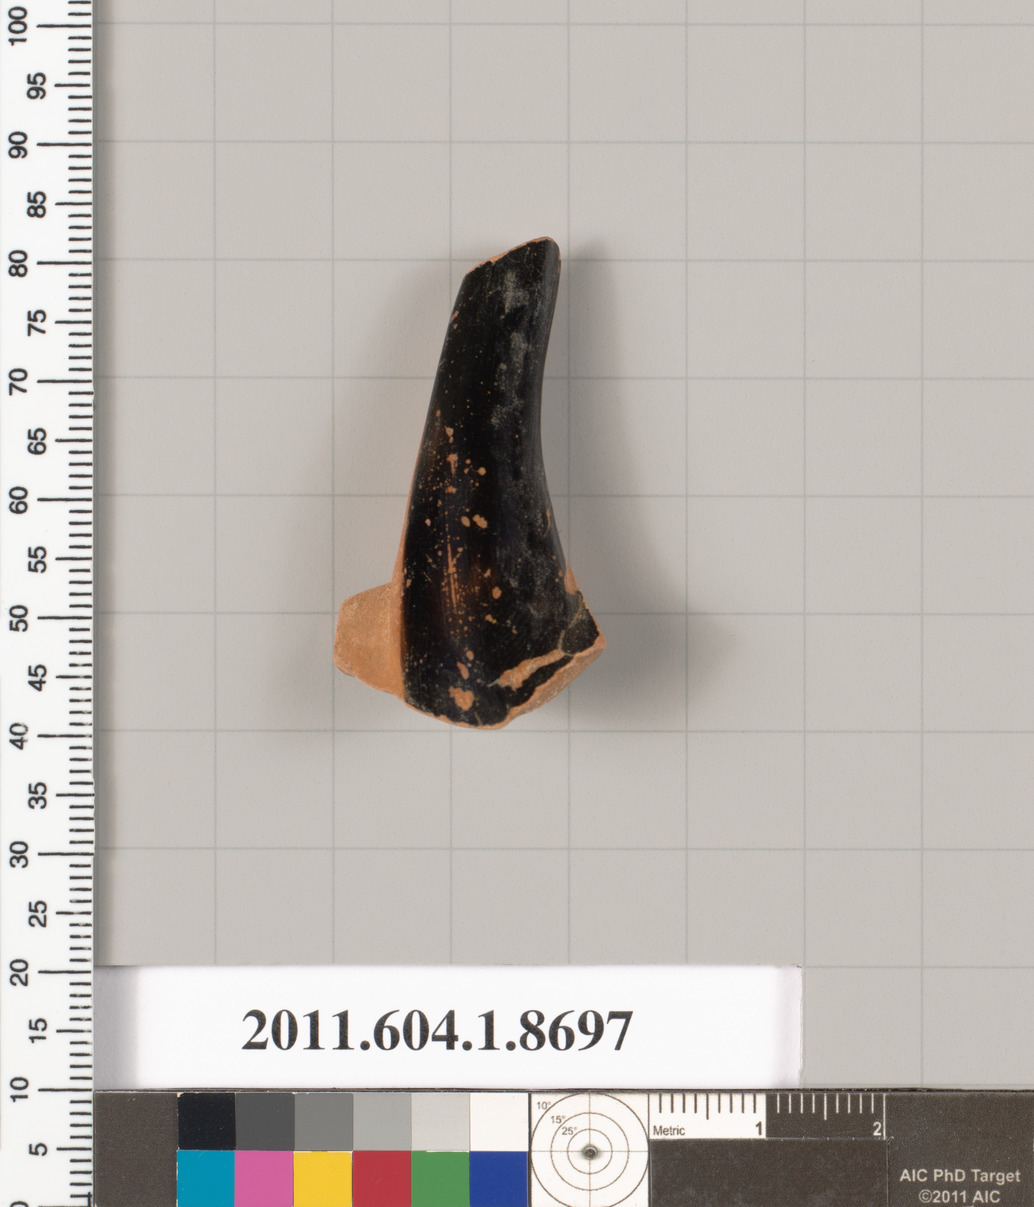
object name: kylix fragment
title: Terracotta fragment of a stemless kylix (drinking cup)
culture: greek, attic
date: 470-450 BCE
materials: terracotta